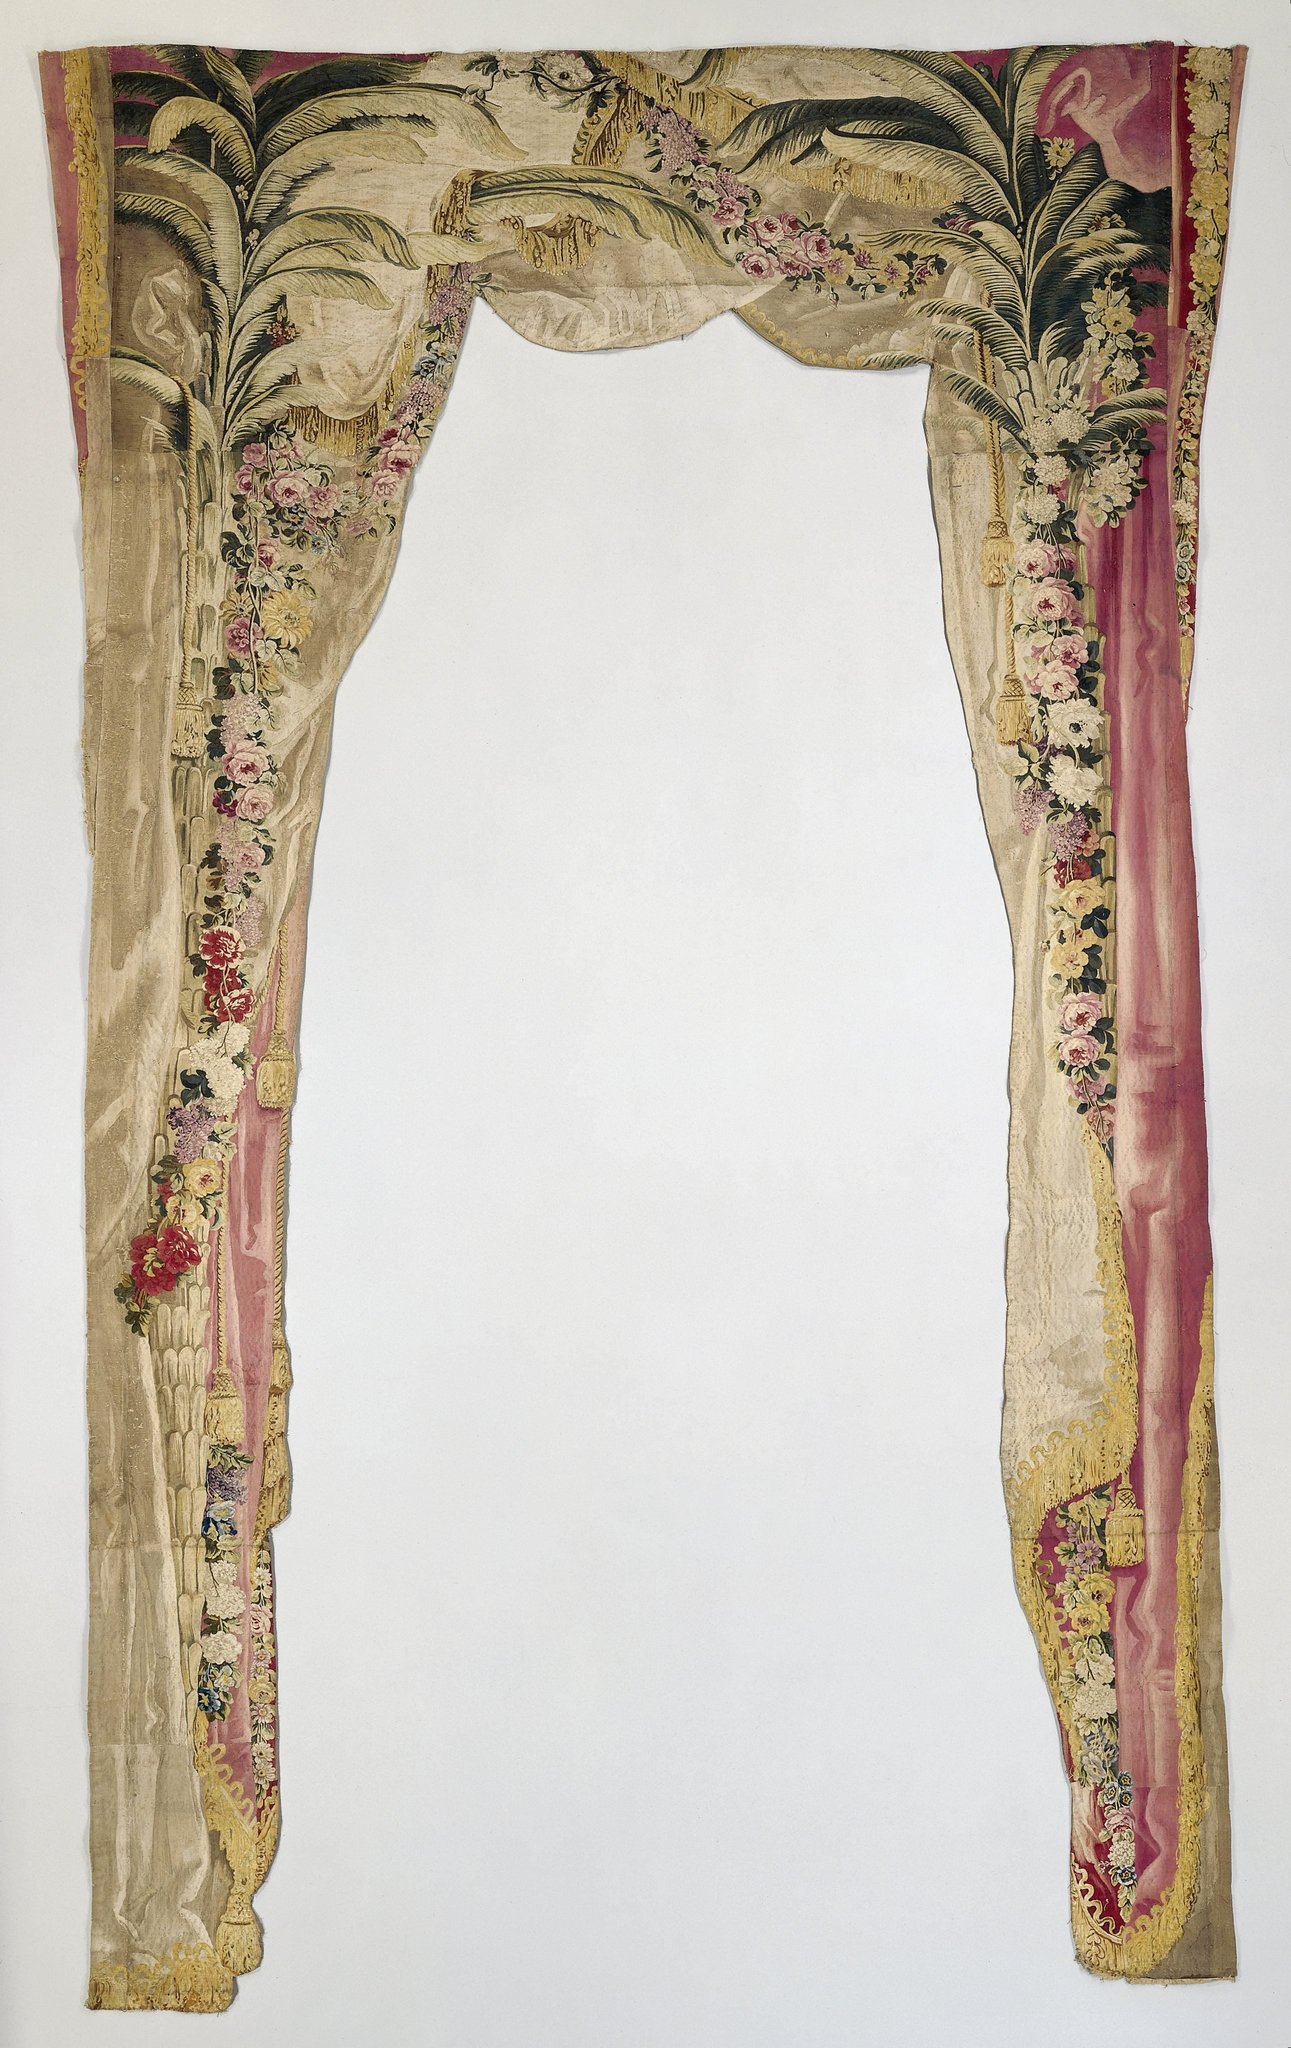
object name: cantonnière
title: Cantonnière met draperieën, palmbomen en bloemguirlandes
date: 1860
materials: silk, wool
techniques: tapestry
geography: beauvais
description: Cantonnière met gordijn- en palmmotieven.